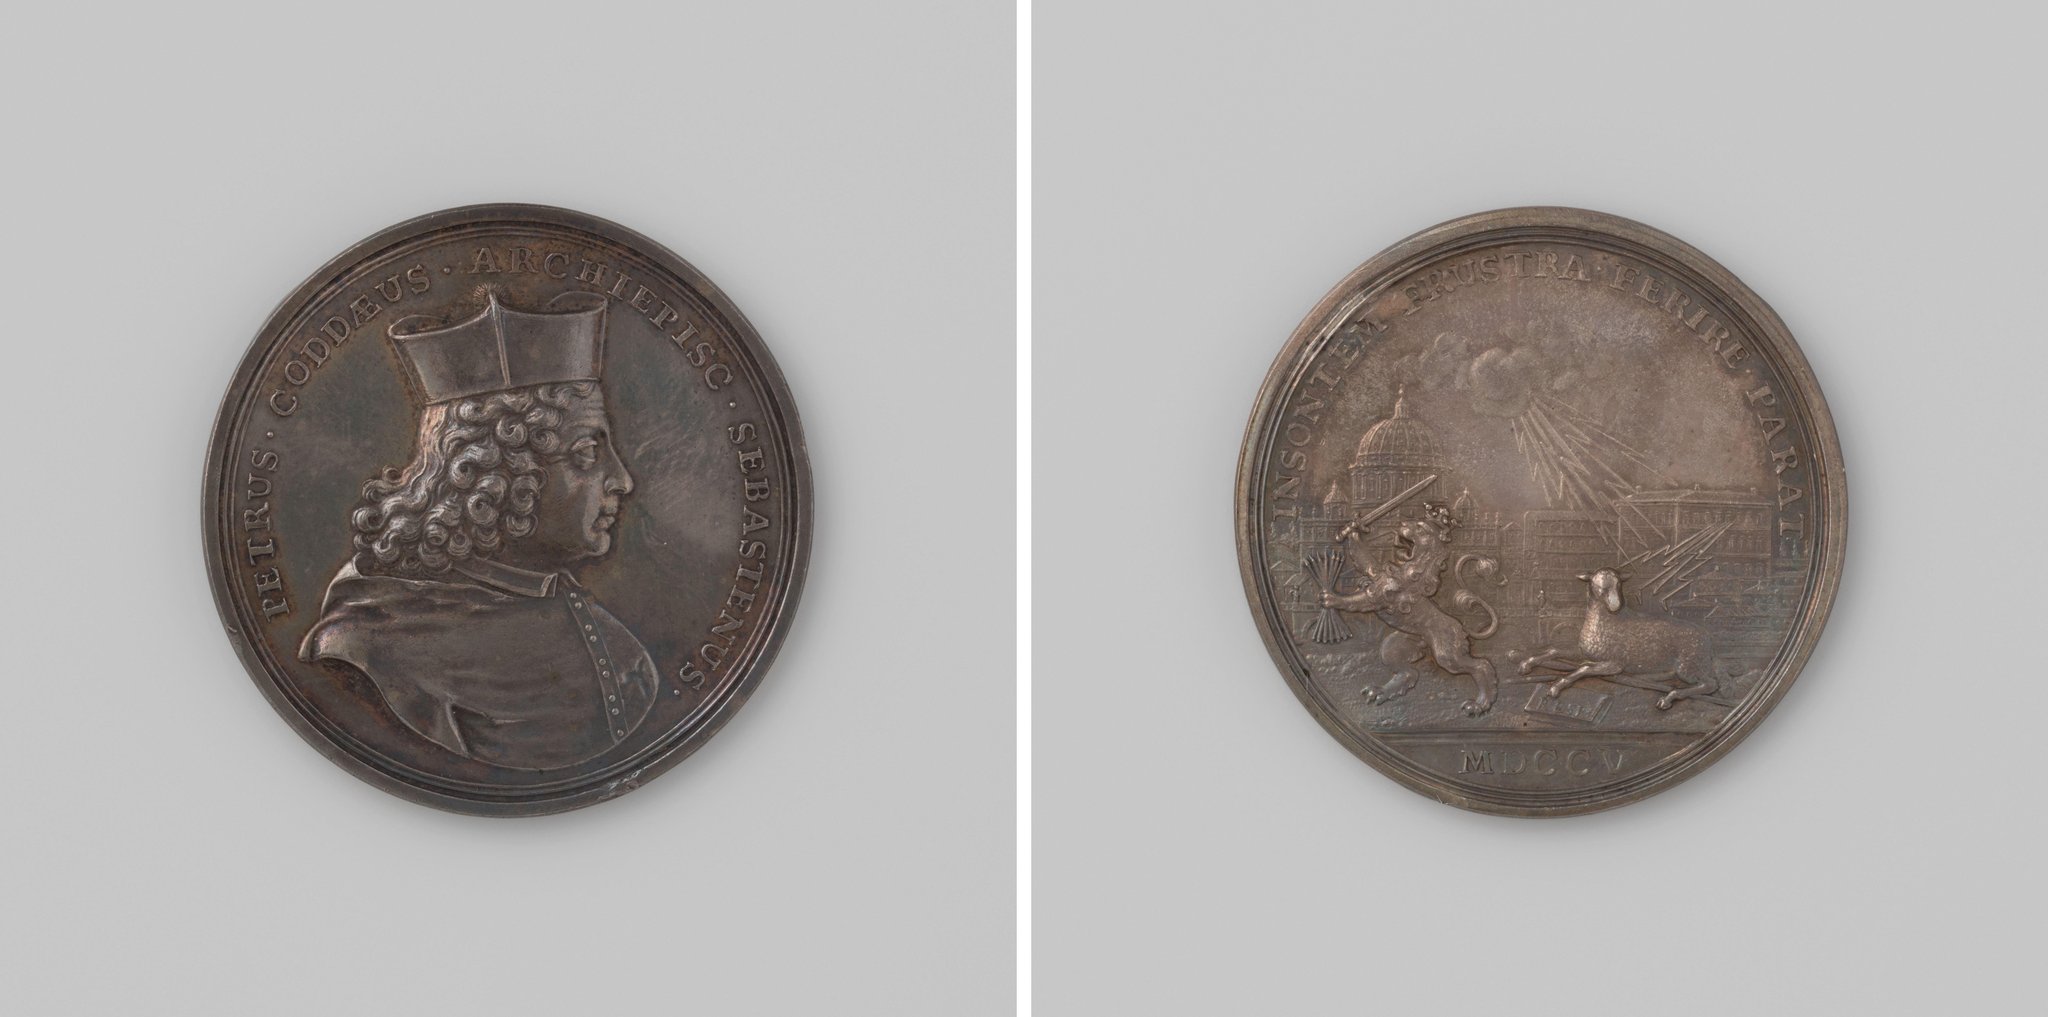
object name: history medal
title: Peter Codde, aartsbisschop van Sebaste door de Staten beschermd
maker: Anonymous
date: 1705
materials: silver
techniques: striking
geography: netherlands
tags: amsterdam, utrecht